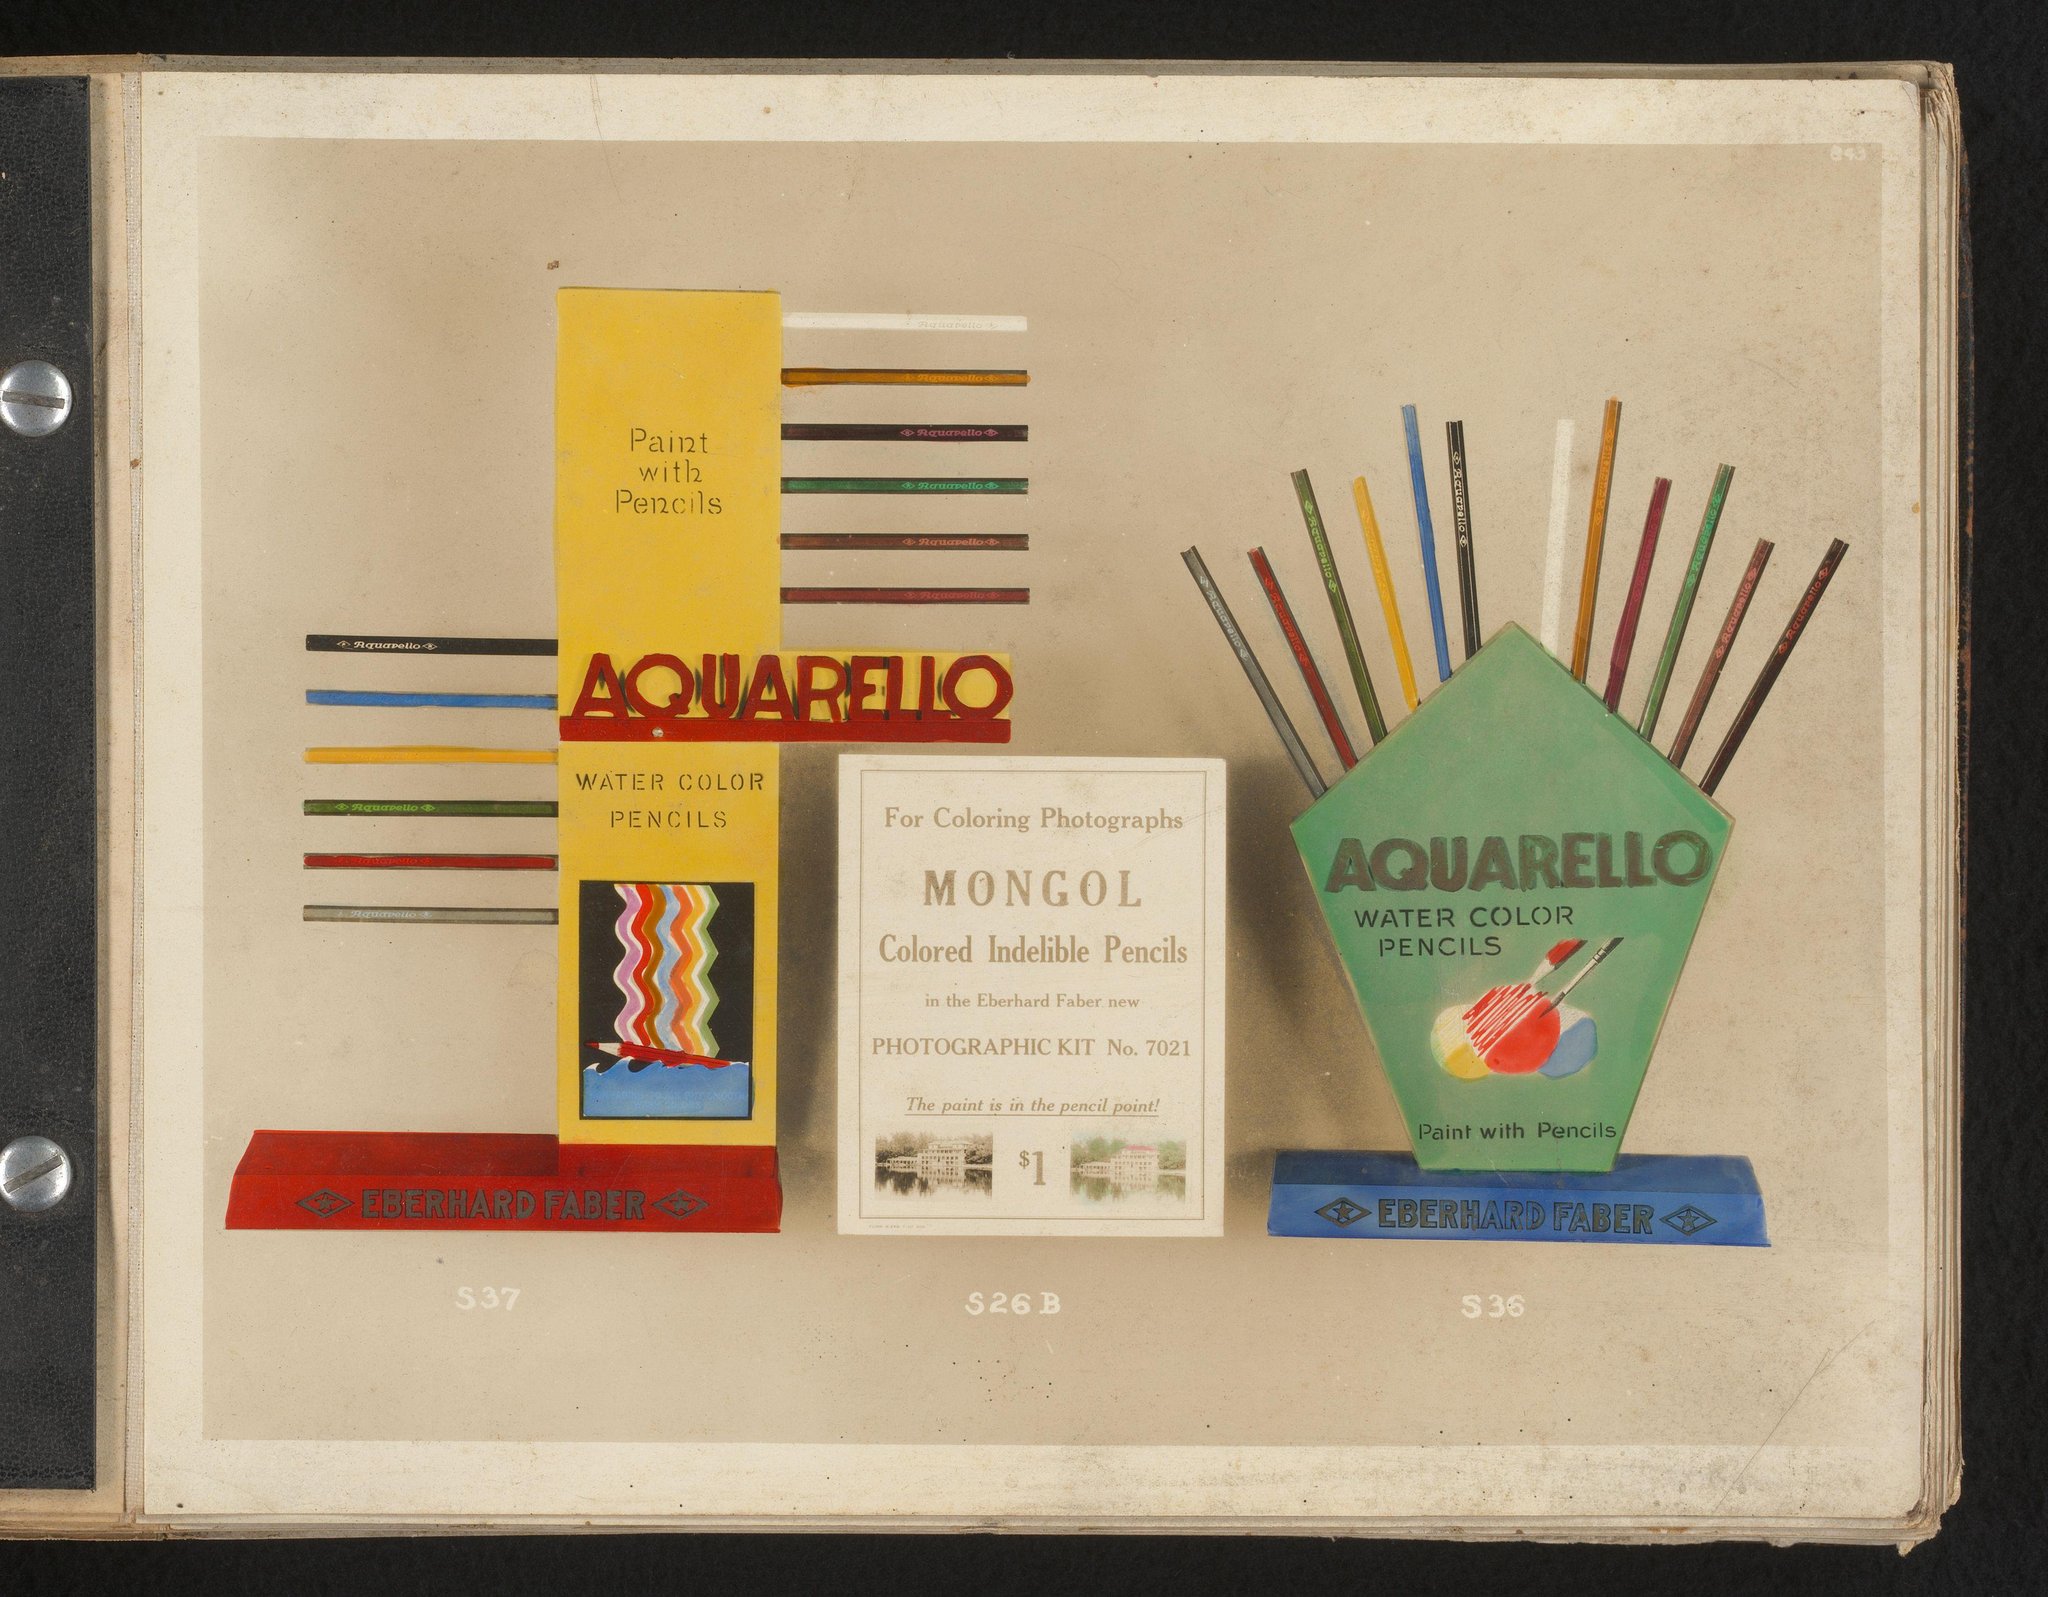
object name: photograph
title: Reclame voor aquarelpotloden van Eberhard Faber, speciaal voor het kleuren van foto's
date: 1915-1935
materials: paper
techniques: gelatin silver print, hand coloring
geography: springfield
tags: pencil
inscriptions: number: ‘843’, stamp: ‘Paramount/ Commercial Studios/ 145 Chestnut St./ Springfield - Mass.’